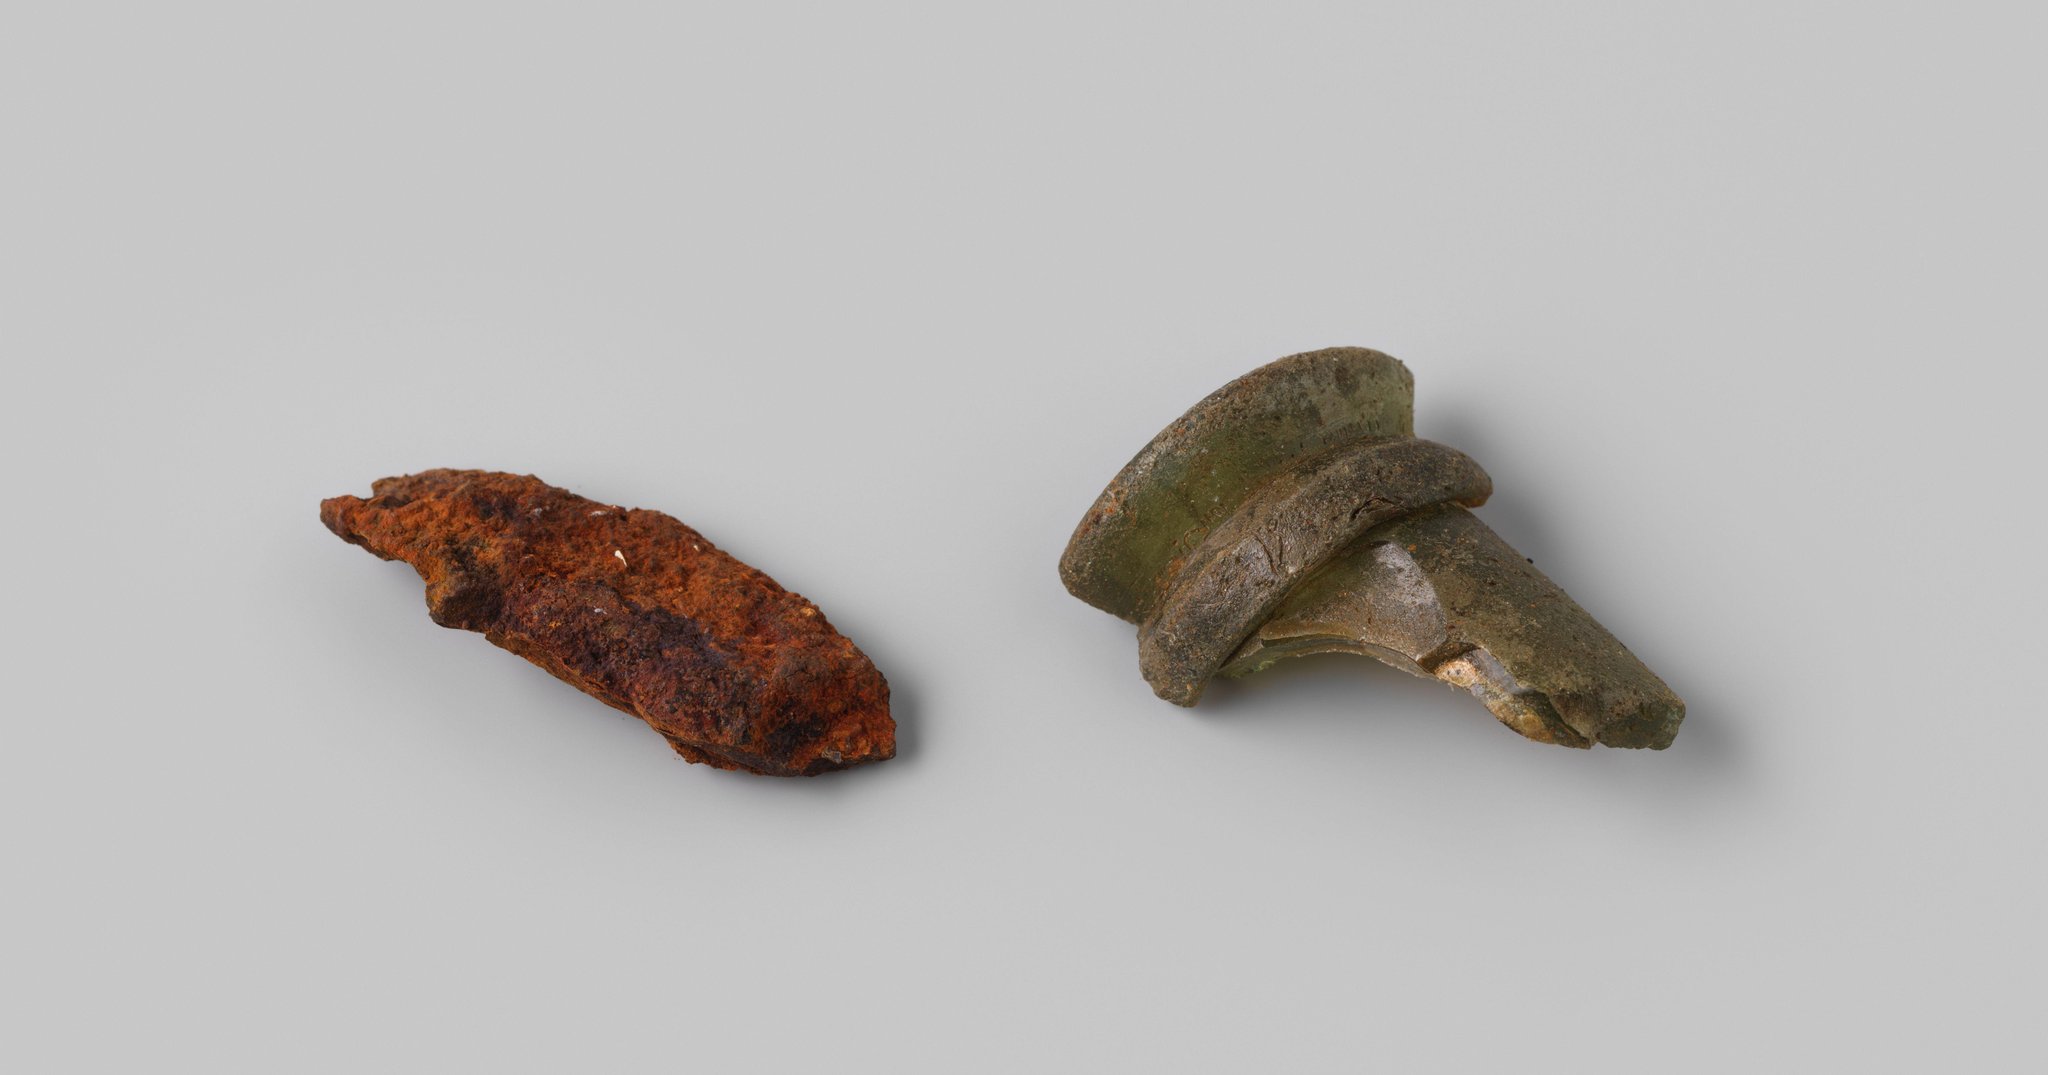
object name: sherd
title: Scherven van wijnflessen uit het wrak van de Oost-Indiëvaarder Hollandia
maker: Anonymous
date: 1700-1743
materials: stone, glass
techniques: green glass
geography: netherlands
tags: verenigde oostindische compagnie, hollandia (schip), annet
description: Wine bottle, continental production, neck, onion-shaped bottle or bottle with vertical side; fragm, vs-string rim.